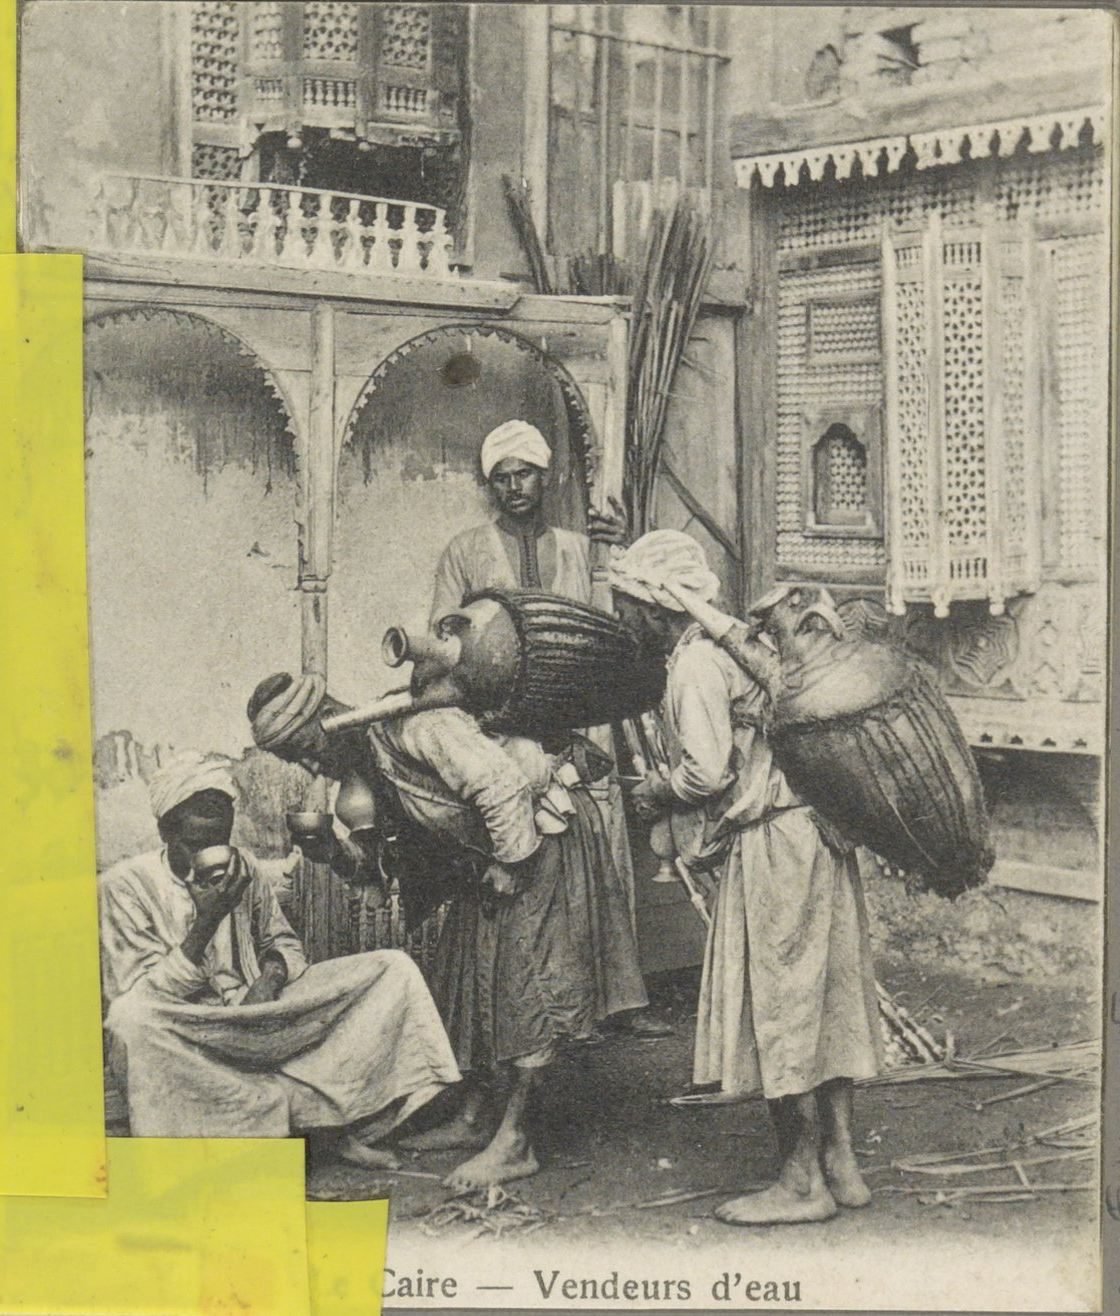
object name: ansichtkaart, prentbriefkaart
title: Waterverkopers met klant in Caïro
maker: Anonymous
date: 1895-1905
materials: paper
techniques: photograph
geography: cairo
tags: carrying something, wandering or travelling merchant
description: Onderdeel van Reisalbum met foto's van bezienswaardigheden in Griekenland en Egypte.